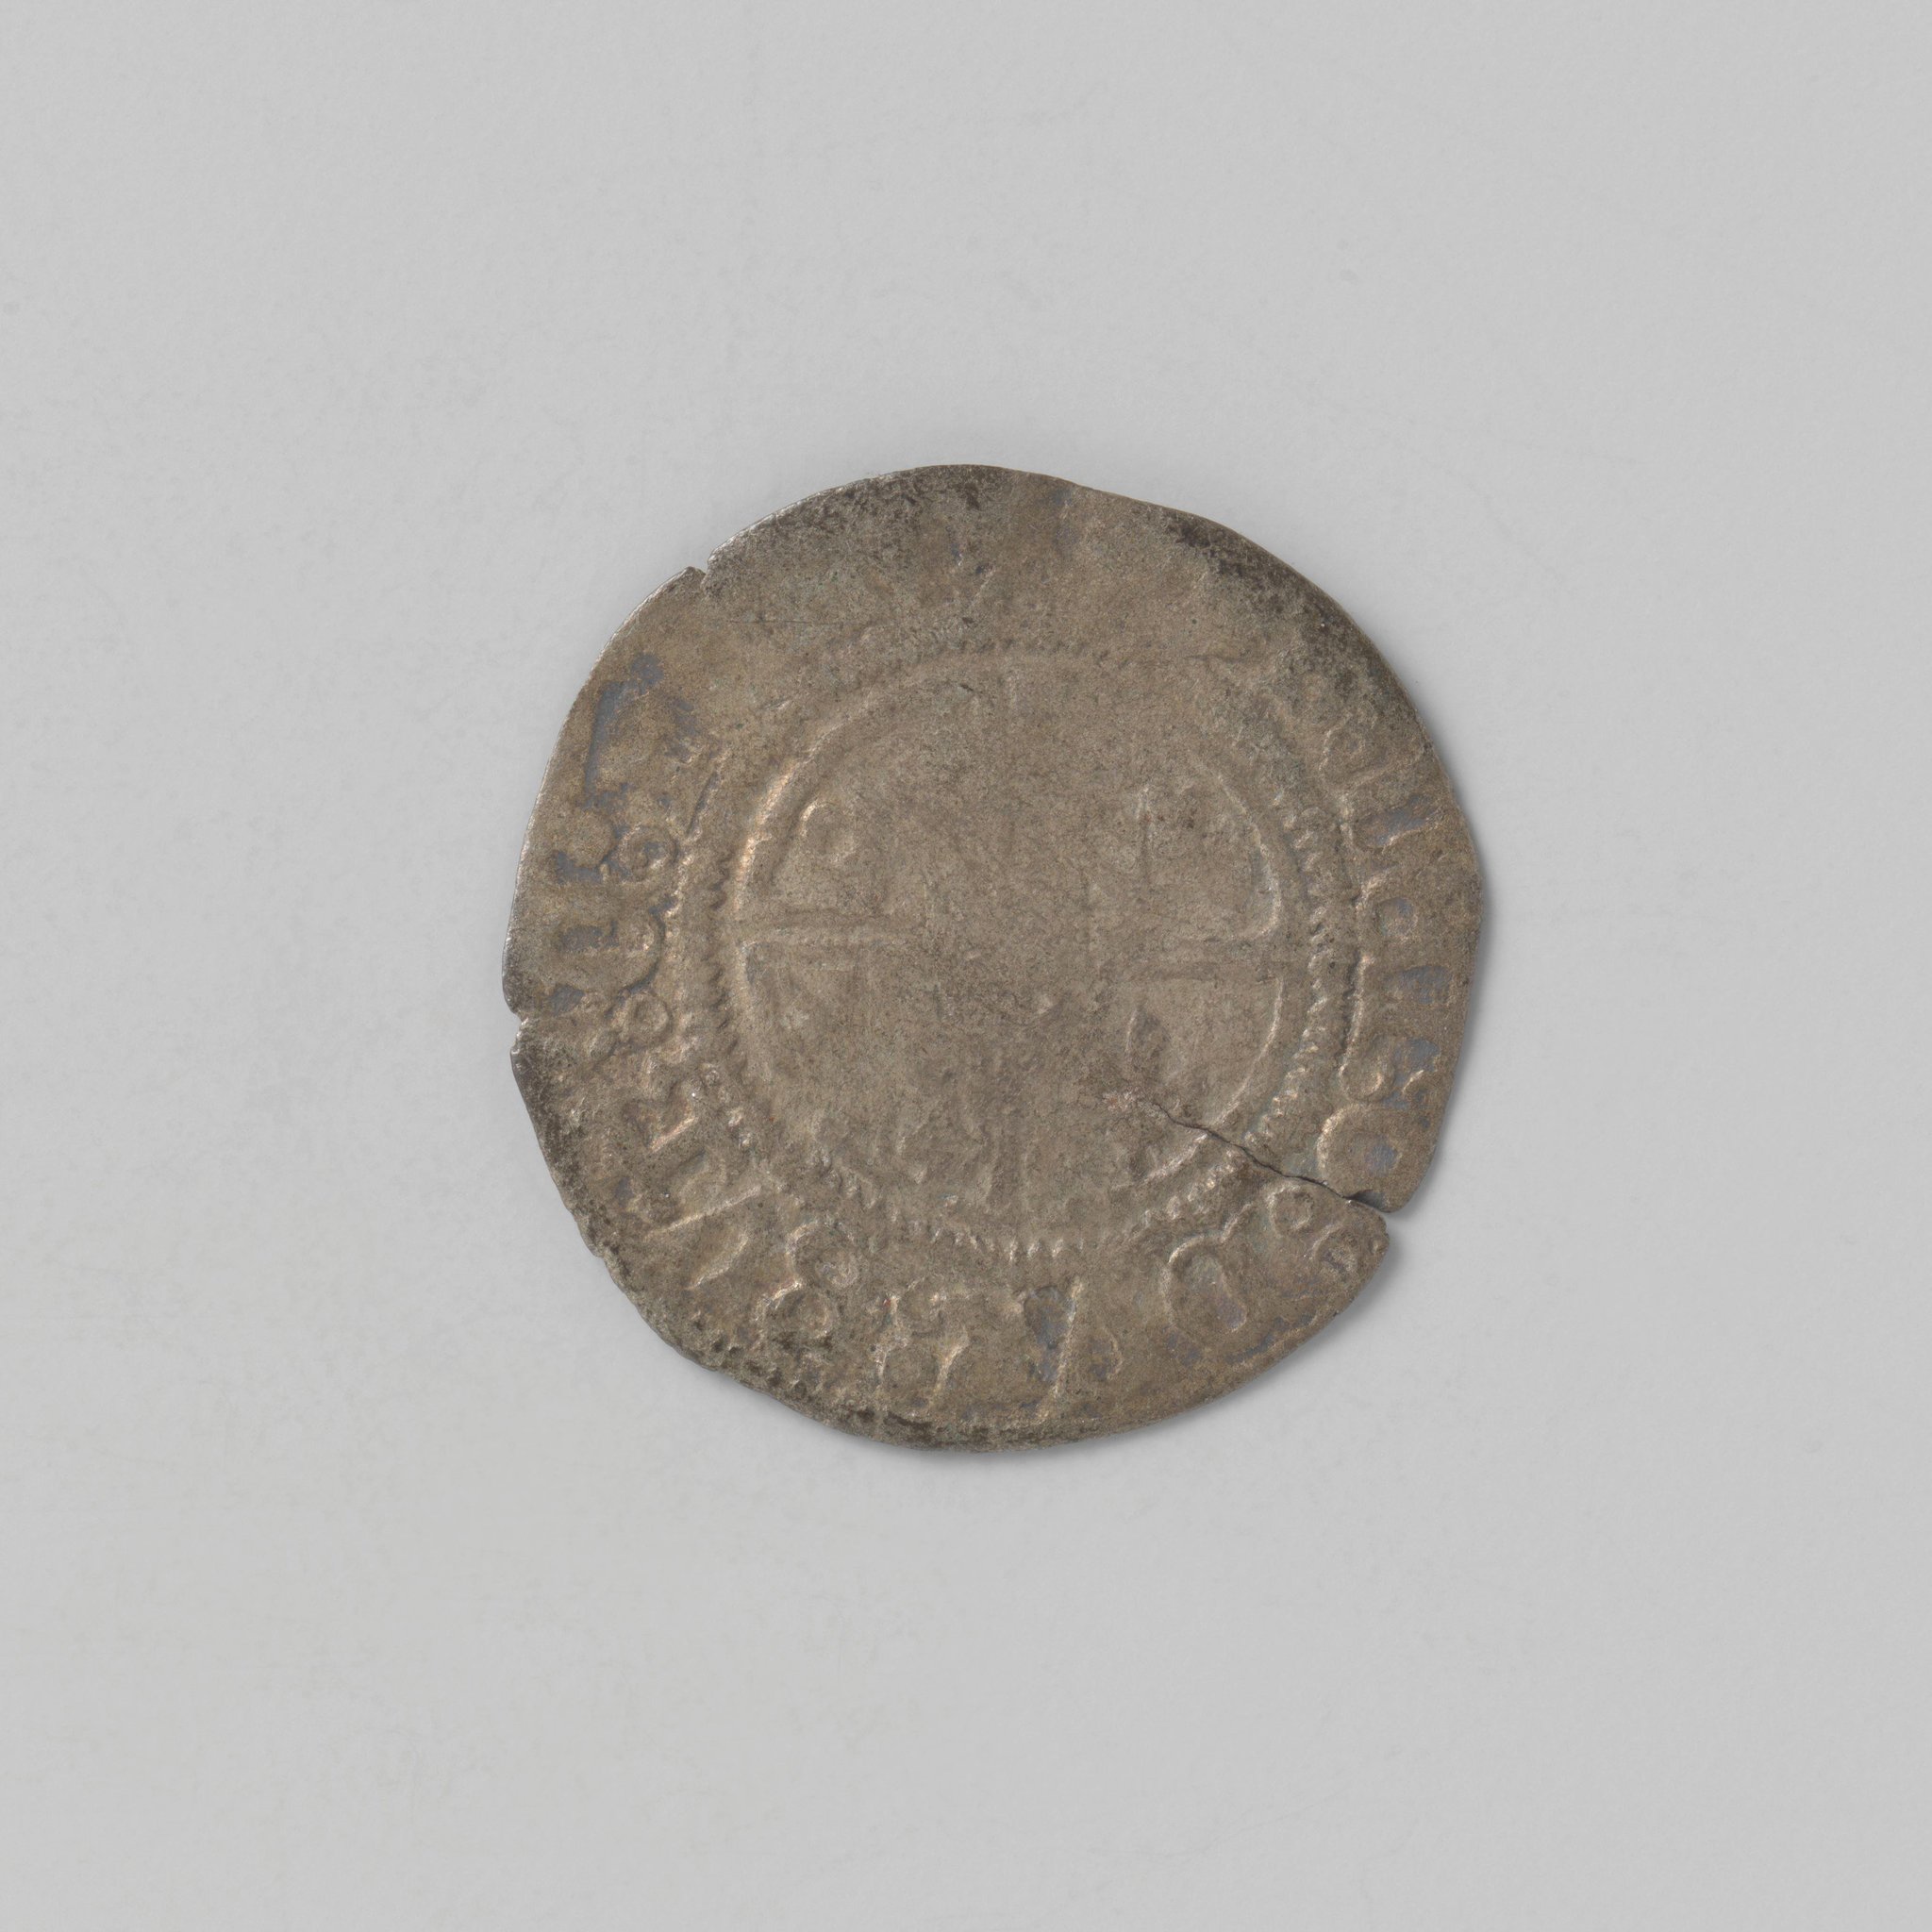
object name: kwart groot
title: Holland, Phliips de Goede, kwart groot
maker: philip iii the good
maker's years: 1396-1467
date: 1434-1440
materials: silver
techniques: striking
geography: dordrecht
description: Zilveren munt. Voorzijde: wapenschild van Philips de Goede (één lelie) in veld. Keerzijde: kort gevoet kruis, in hoeken afwisselend lelies en leeuwtjes, in het hart roos.